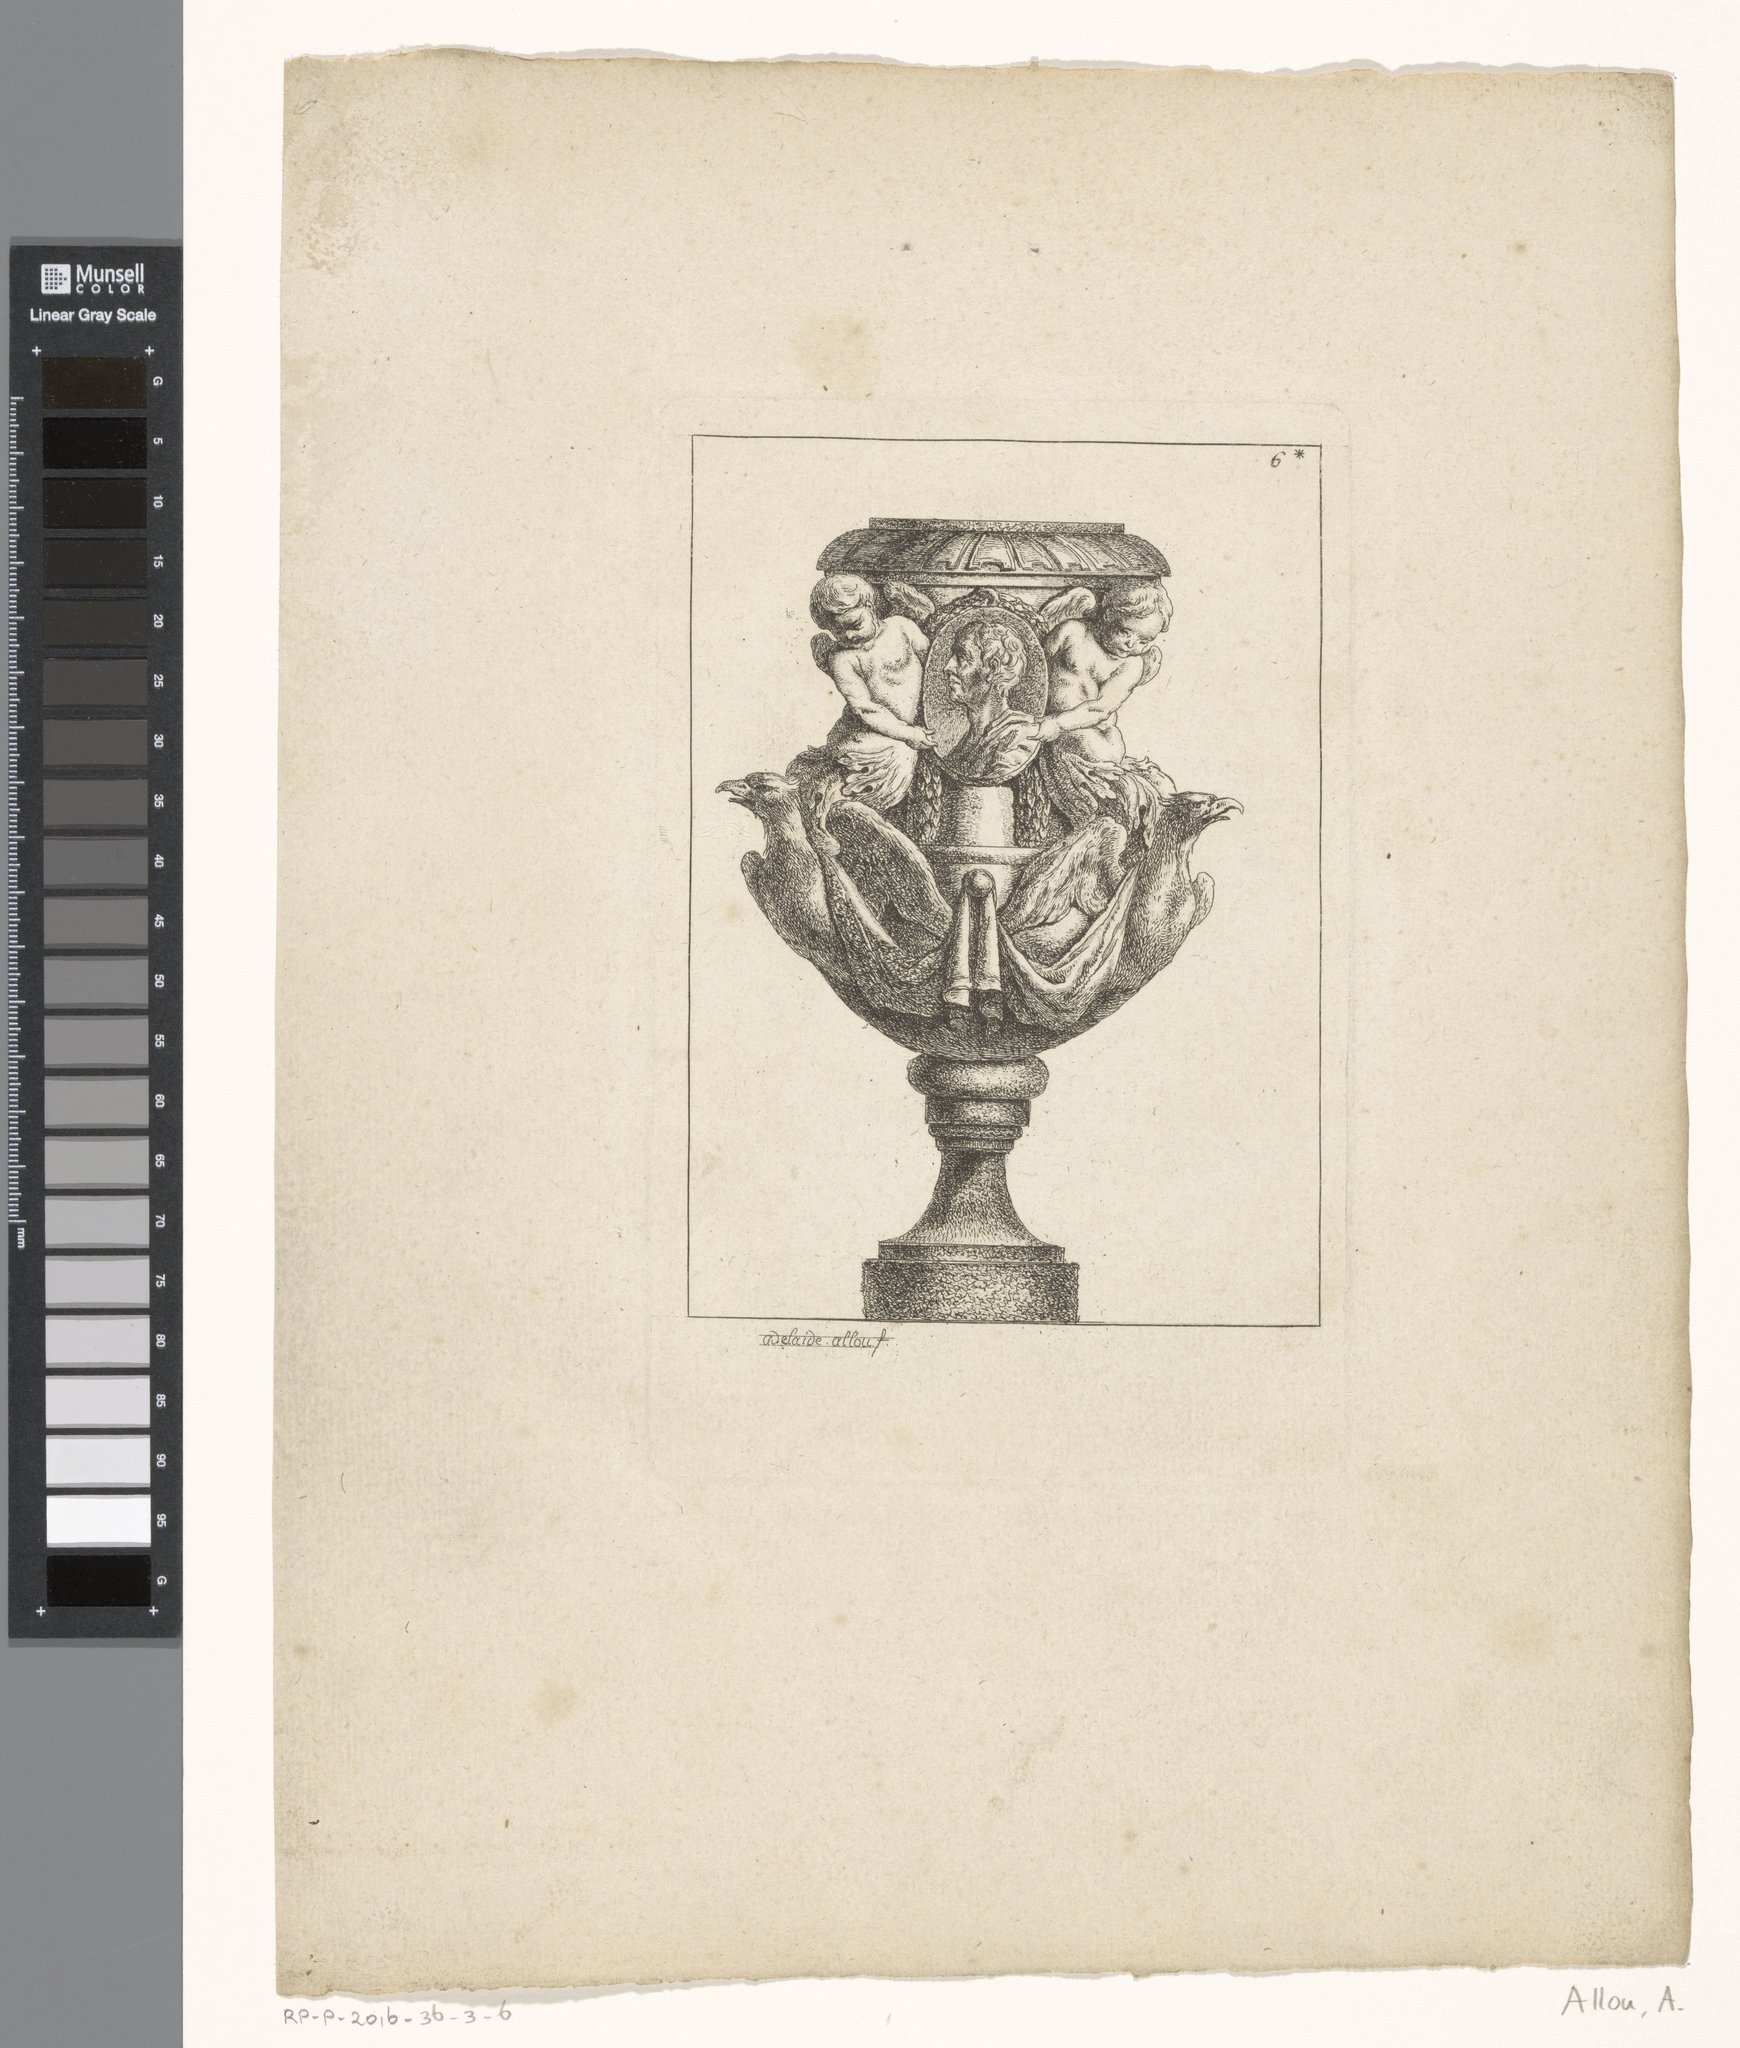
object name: print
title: Vaas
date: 1771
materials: paper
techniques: etching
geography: paris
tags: vase ~ ornament, garden vase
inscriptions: collector's mark: Lugt 2760, collector's mark: Lugt 2228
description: Prent uit een genummerde serie met twaalf vazen door Allou en Nicolet.